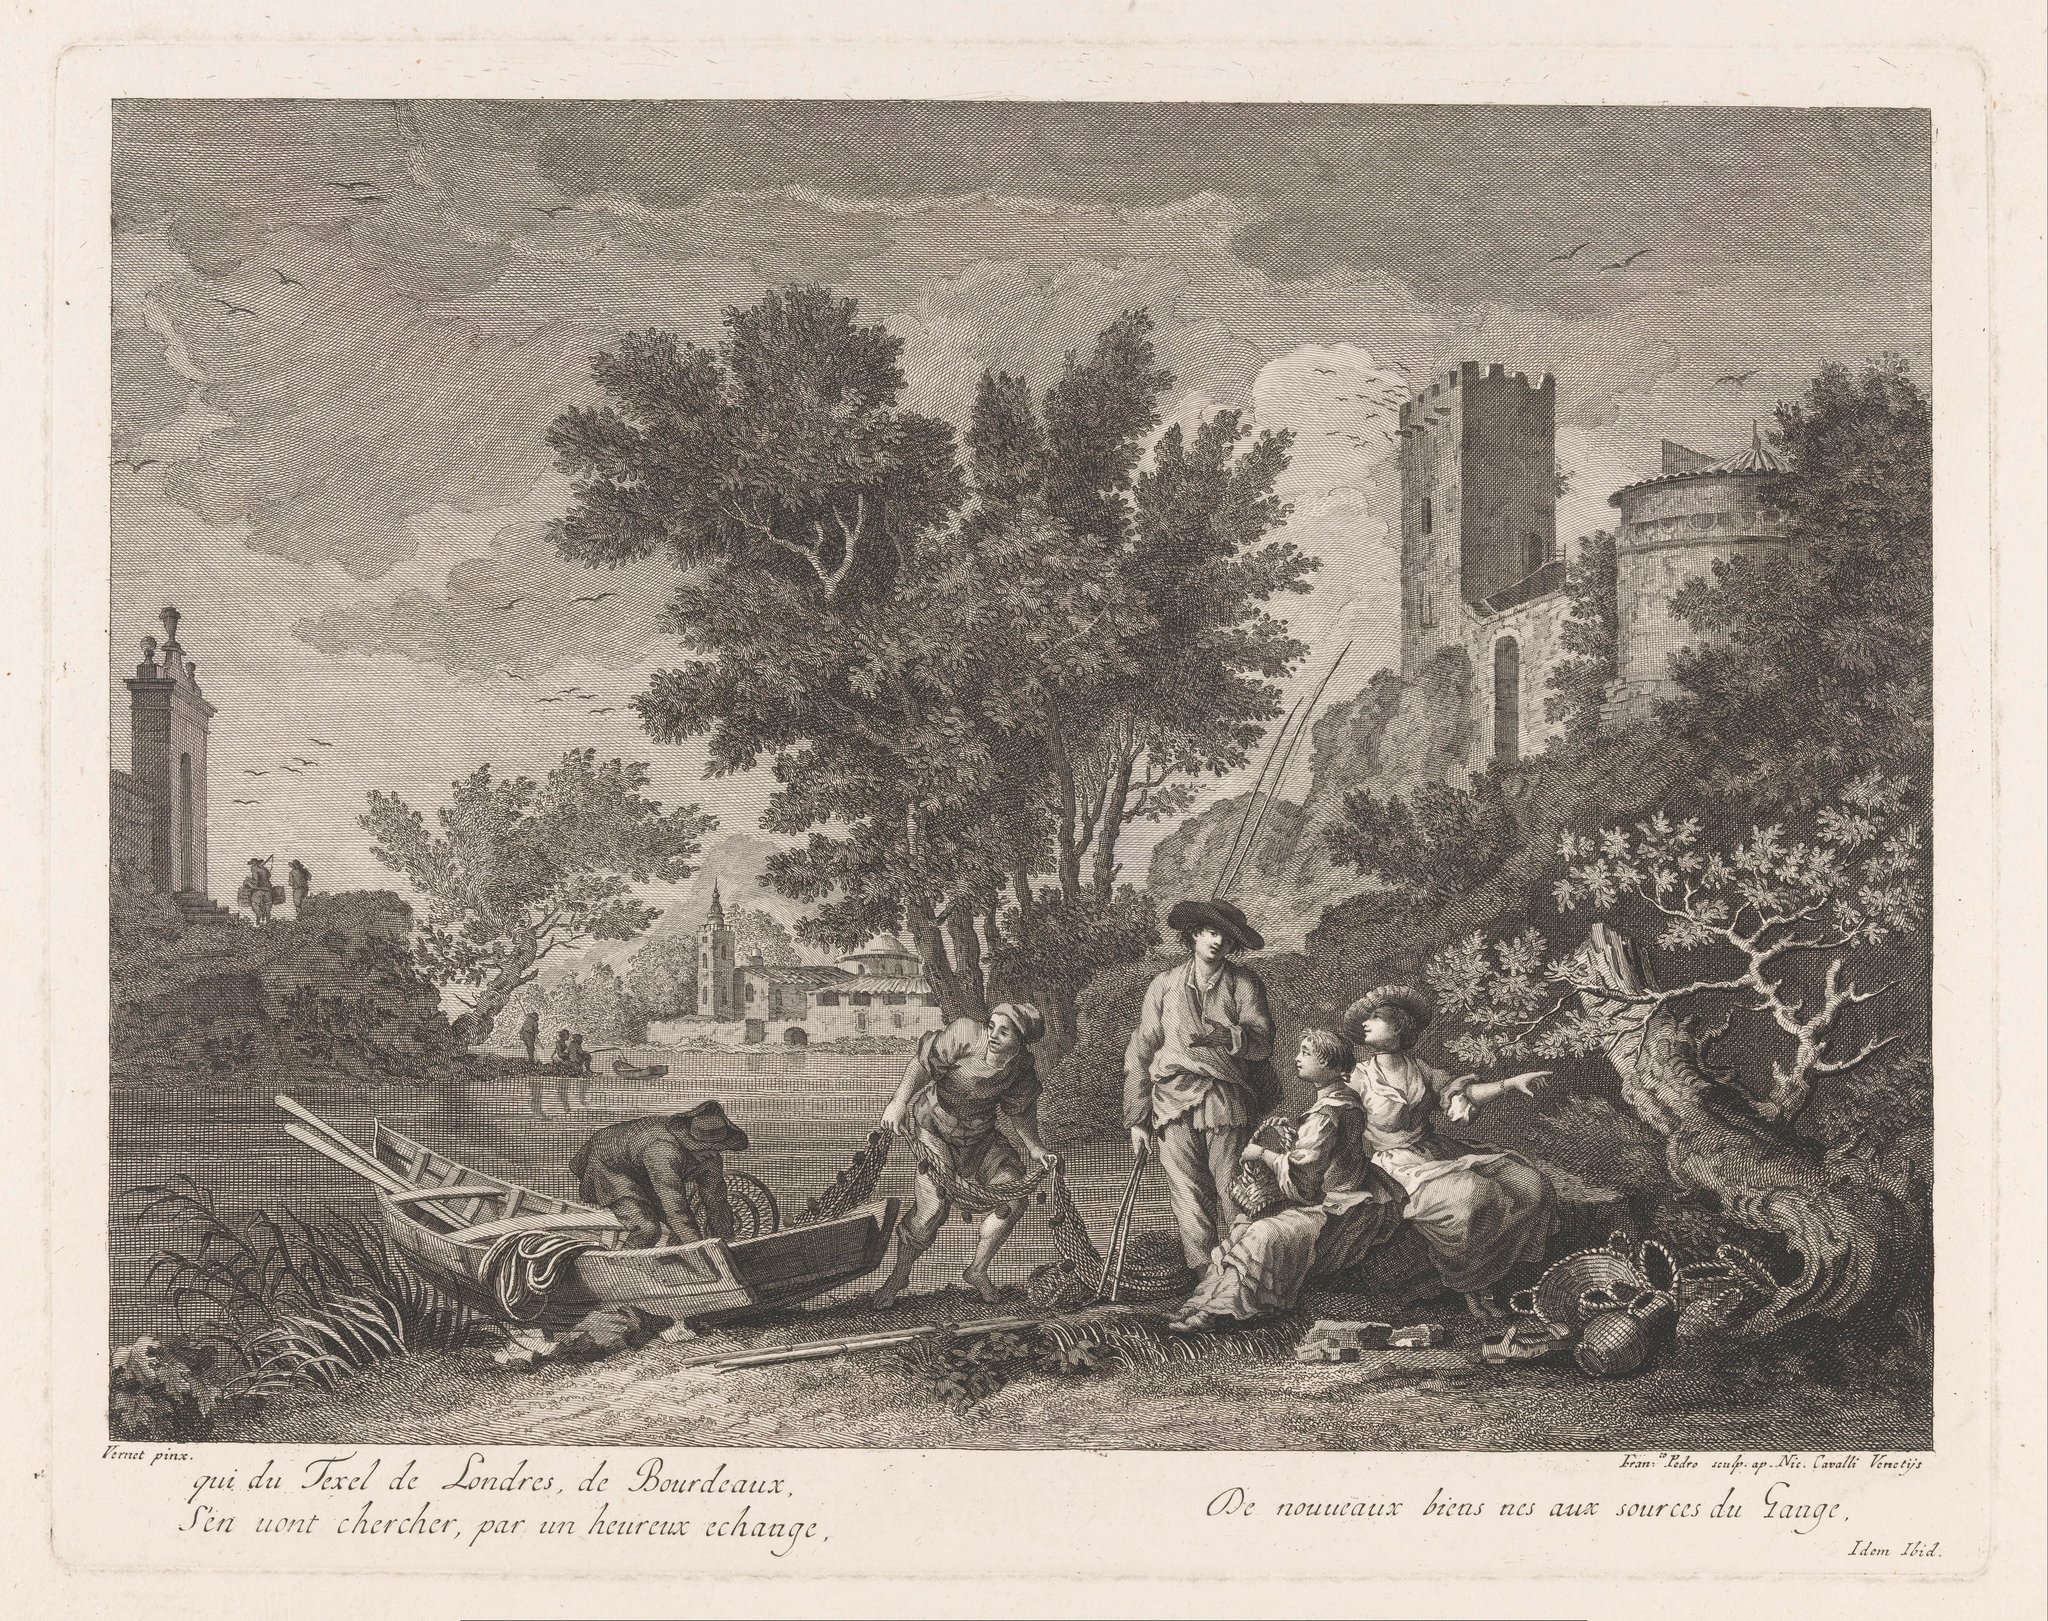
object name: print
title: Landschap met vissers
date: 1749-1806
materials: paper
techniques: engraving, etching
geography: italy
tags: sailing-ship, sailing-boat, fisherman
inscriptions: collector's mark: ‘School voor de grafische vakken te Utrecht’, collector's mark: Lugt 2228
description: Op de voorgrond brengen twee figuren een visnet uit een boot op het land. Aan wal staat een man met twee hengels in zijn hand. Naast hem zitten twee vrouwen. Op de achtergrond andere vissende figuren en gebouwen. In de ondermarge drie verzen uit Voltaire's gedicht 'Le Mondain' (1736).